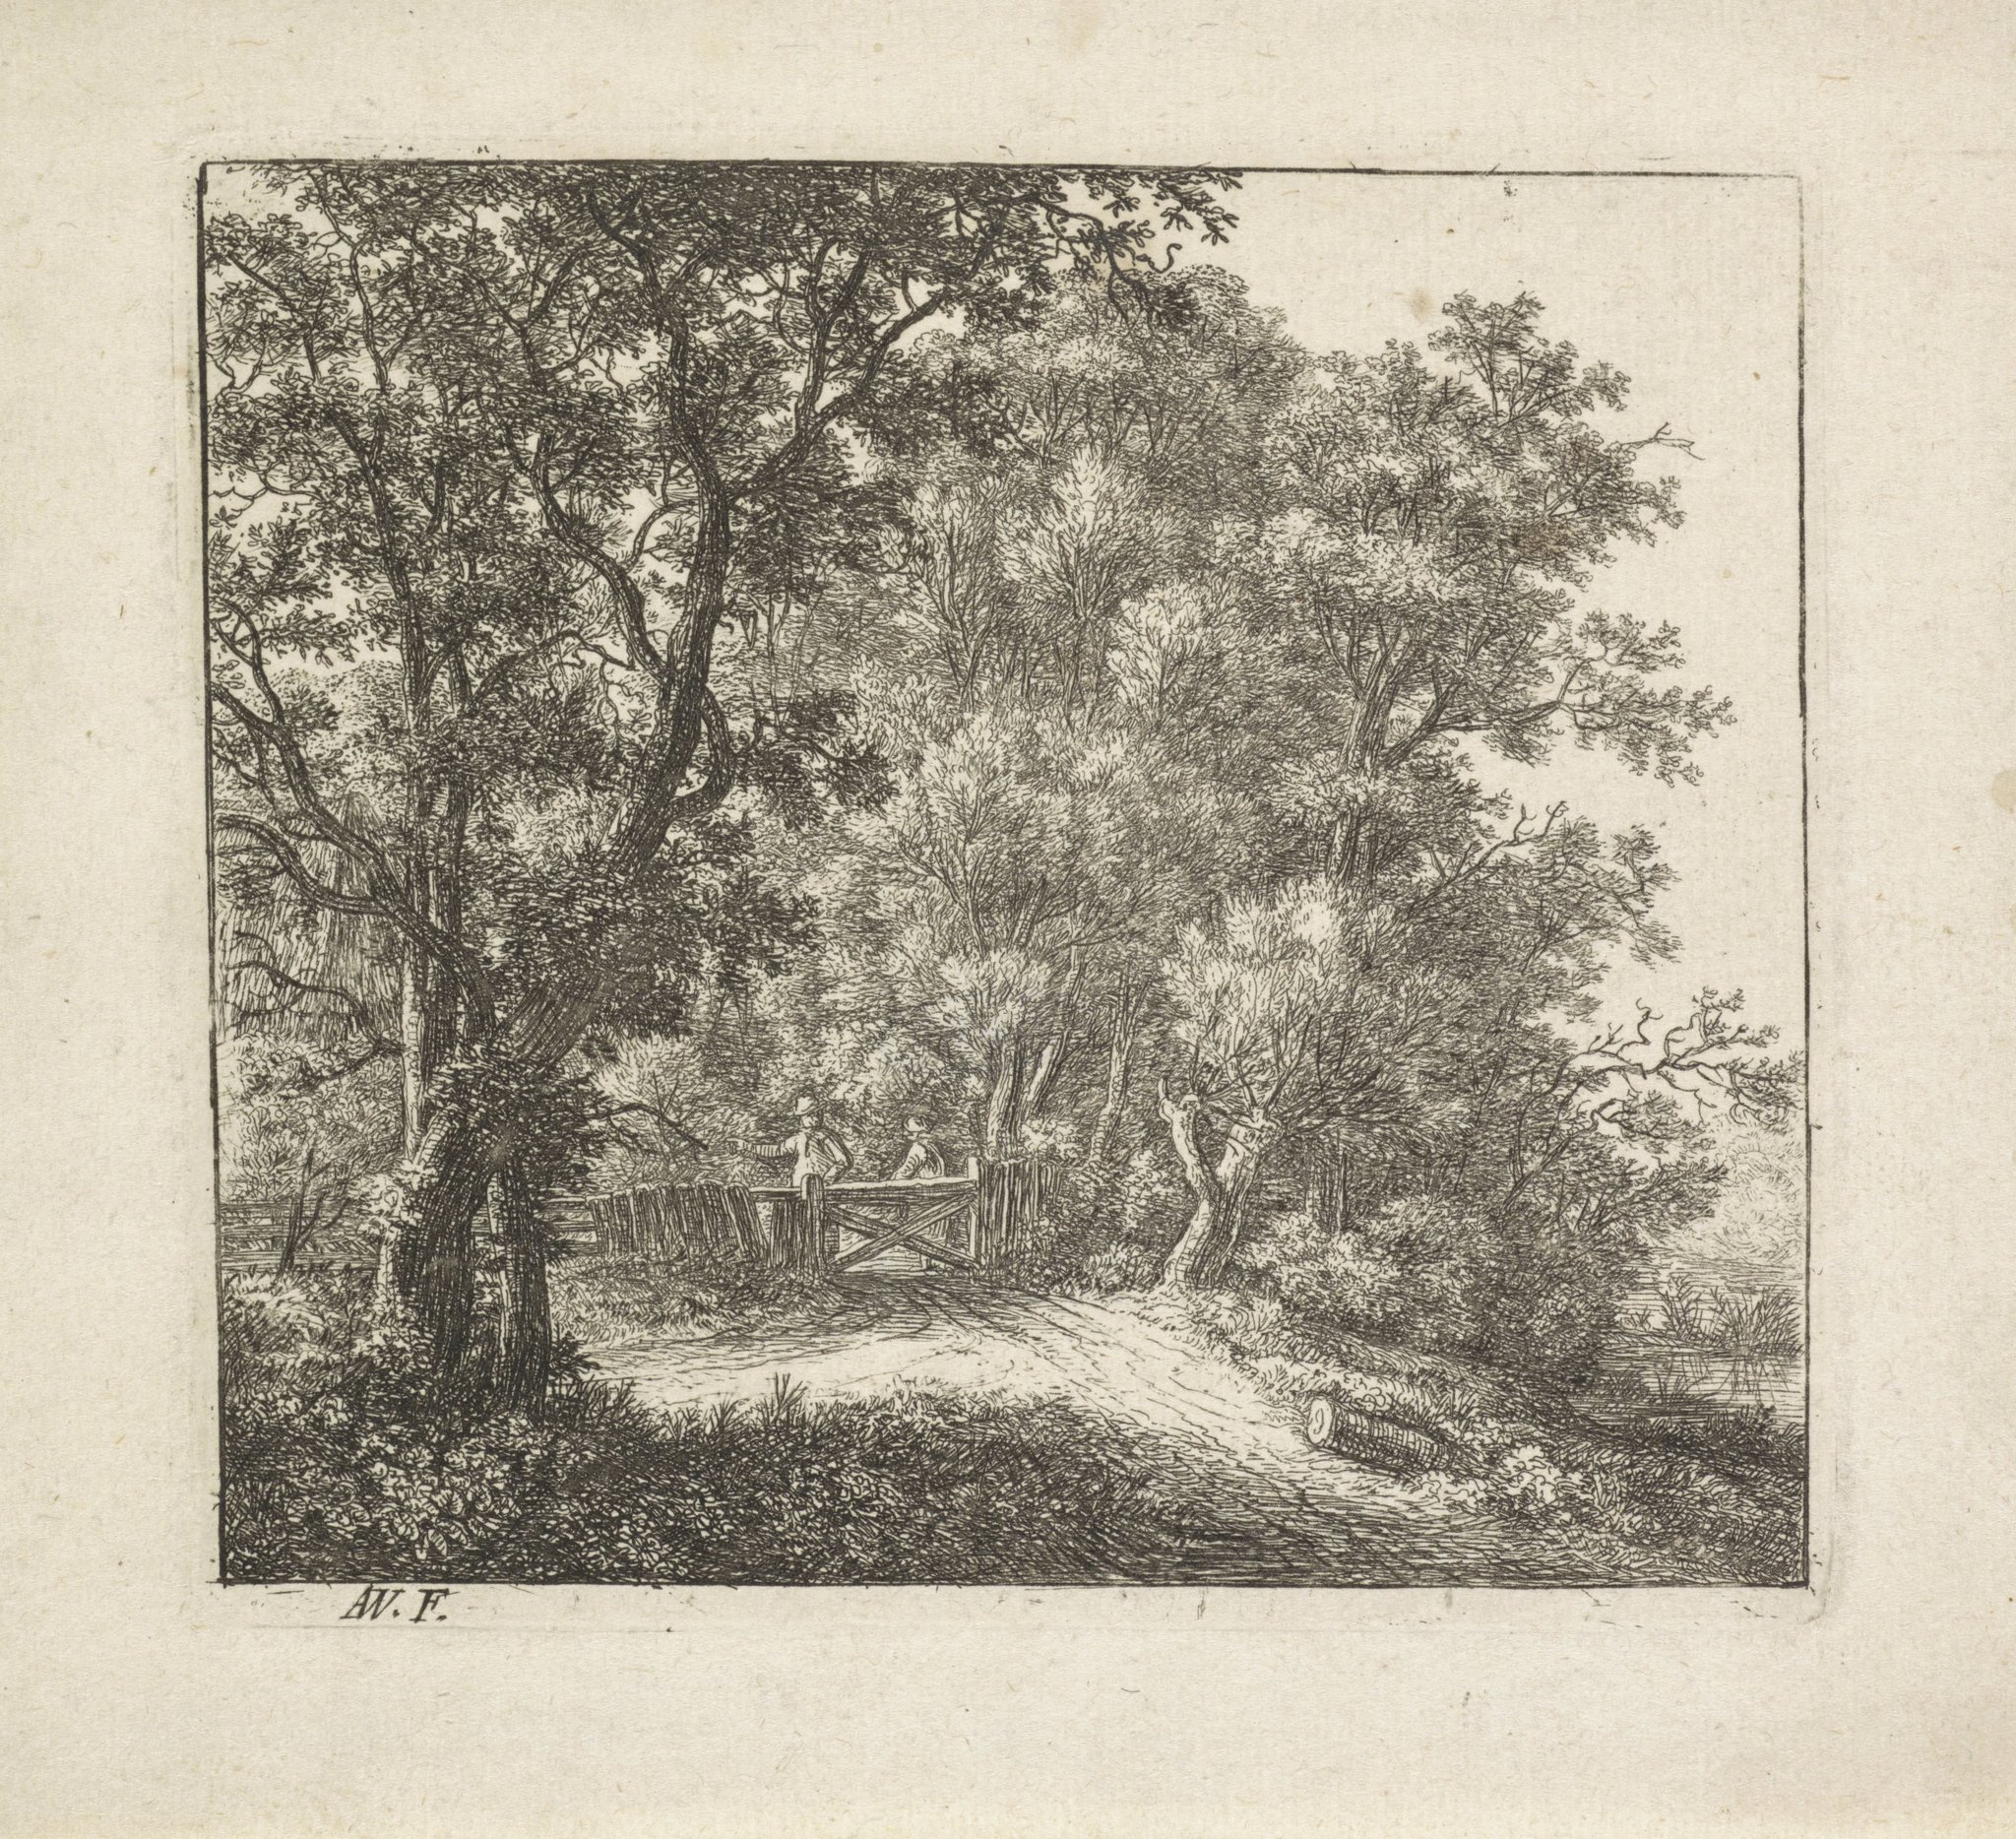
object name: print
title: Twee figuren bij een hek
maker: anthonie waterloo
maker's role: draughtsman, painter, print maker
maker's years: 1609-1690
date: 1630-1663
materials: paper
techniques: etching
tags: fence, wall, paling, forest, wood, landscapes (+ landscape with figures, staffage)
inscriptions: collector's mark: Lugt 2228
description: Zie Hollstein voor een volledig overzicht van de verschillende edities.